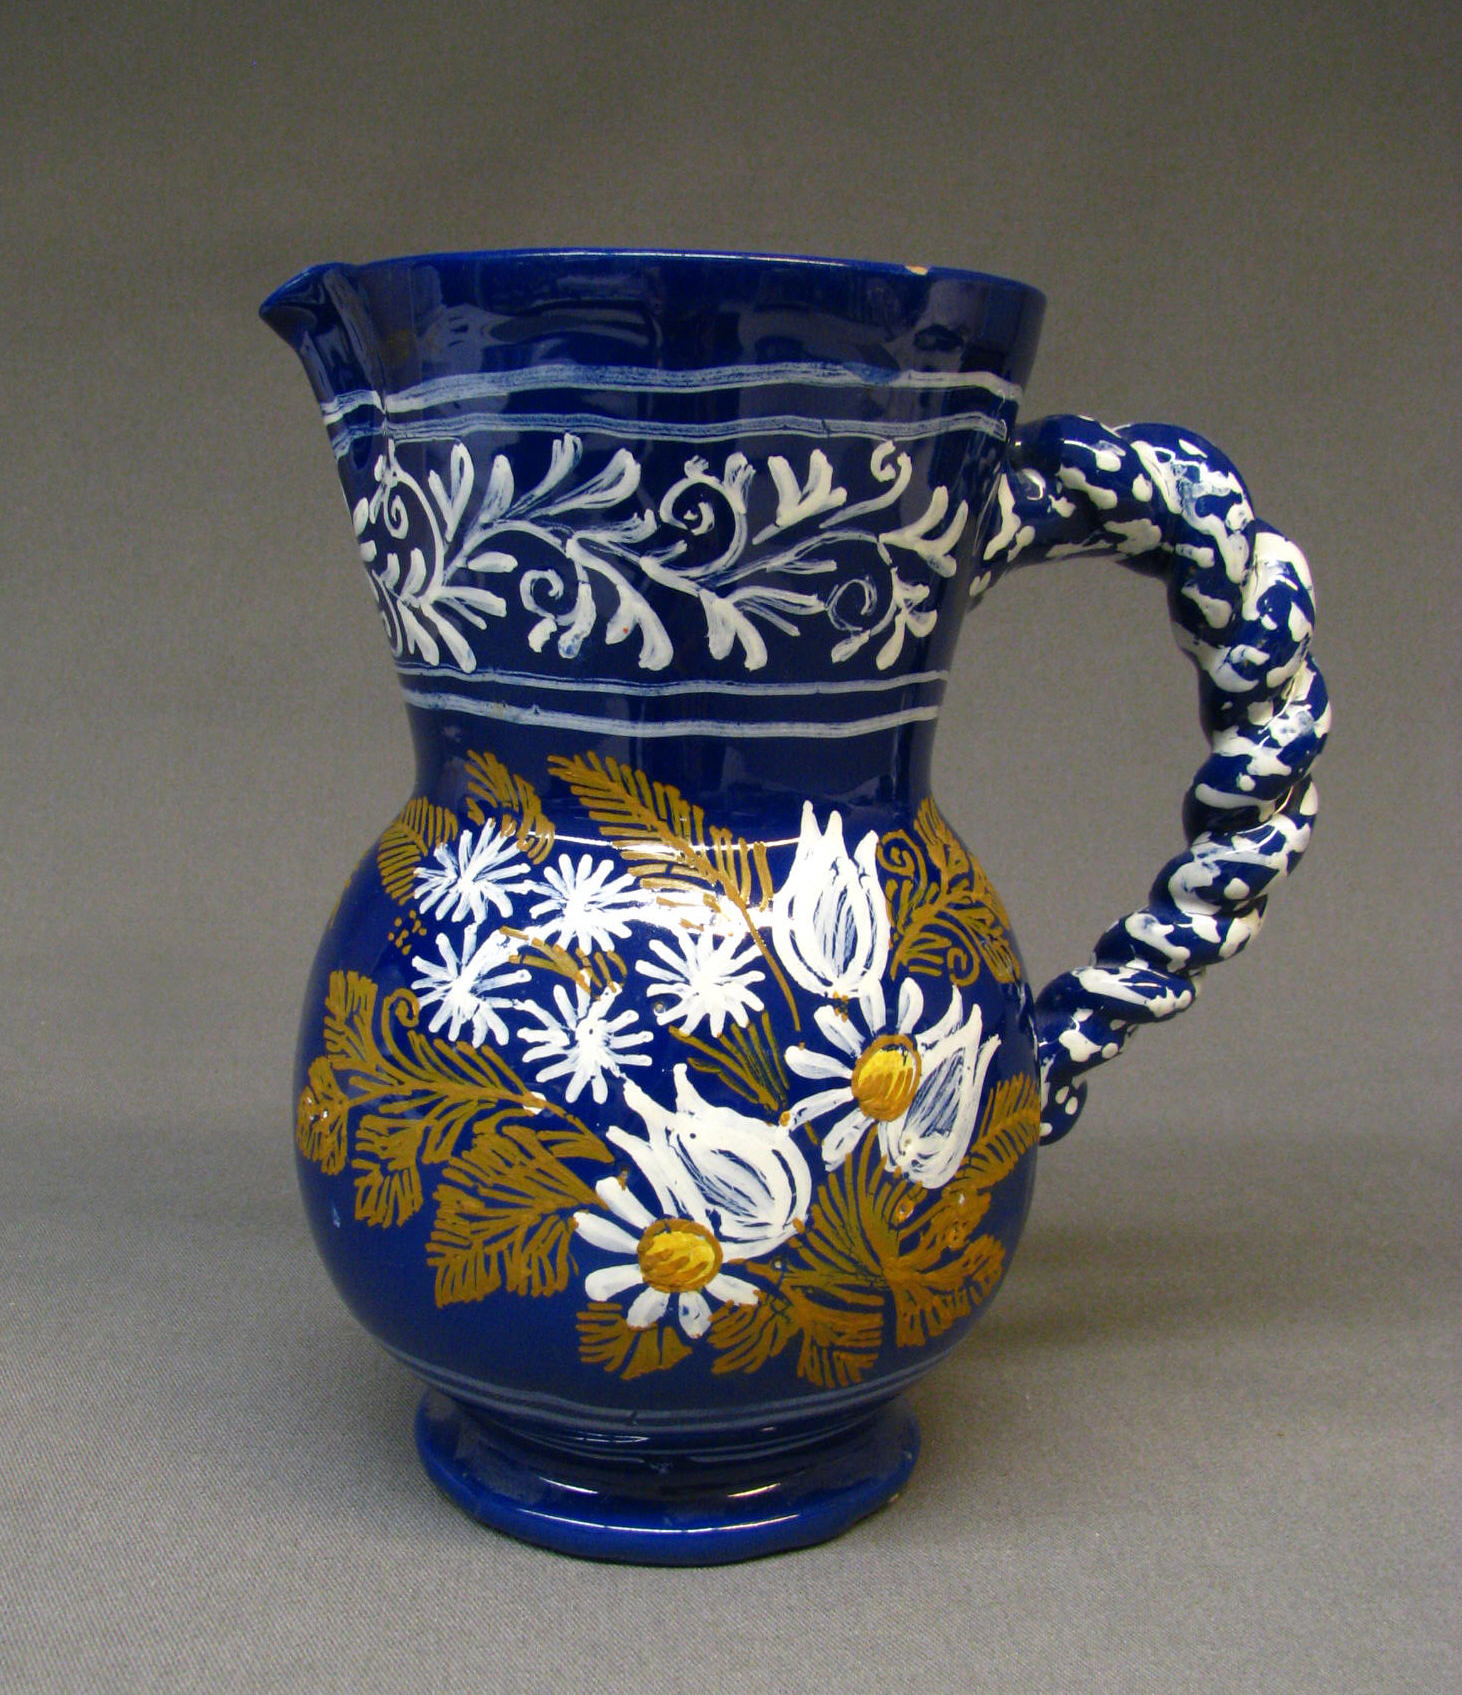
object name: jug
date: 1675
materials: faience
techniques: glazing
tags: flowers